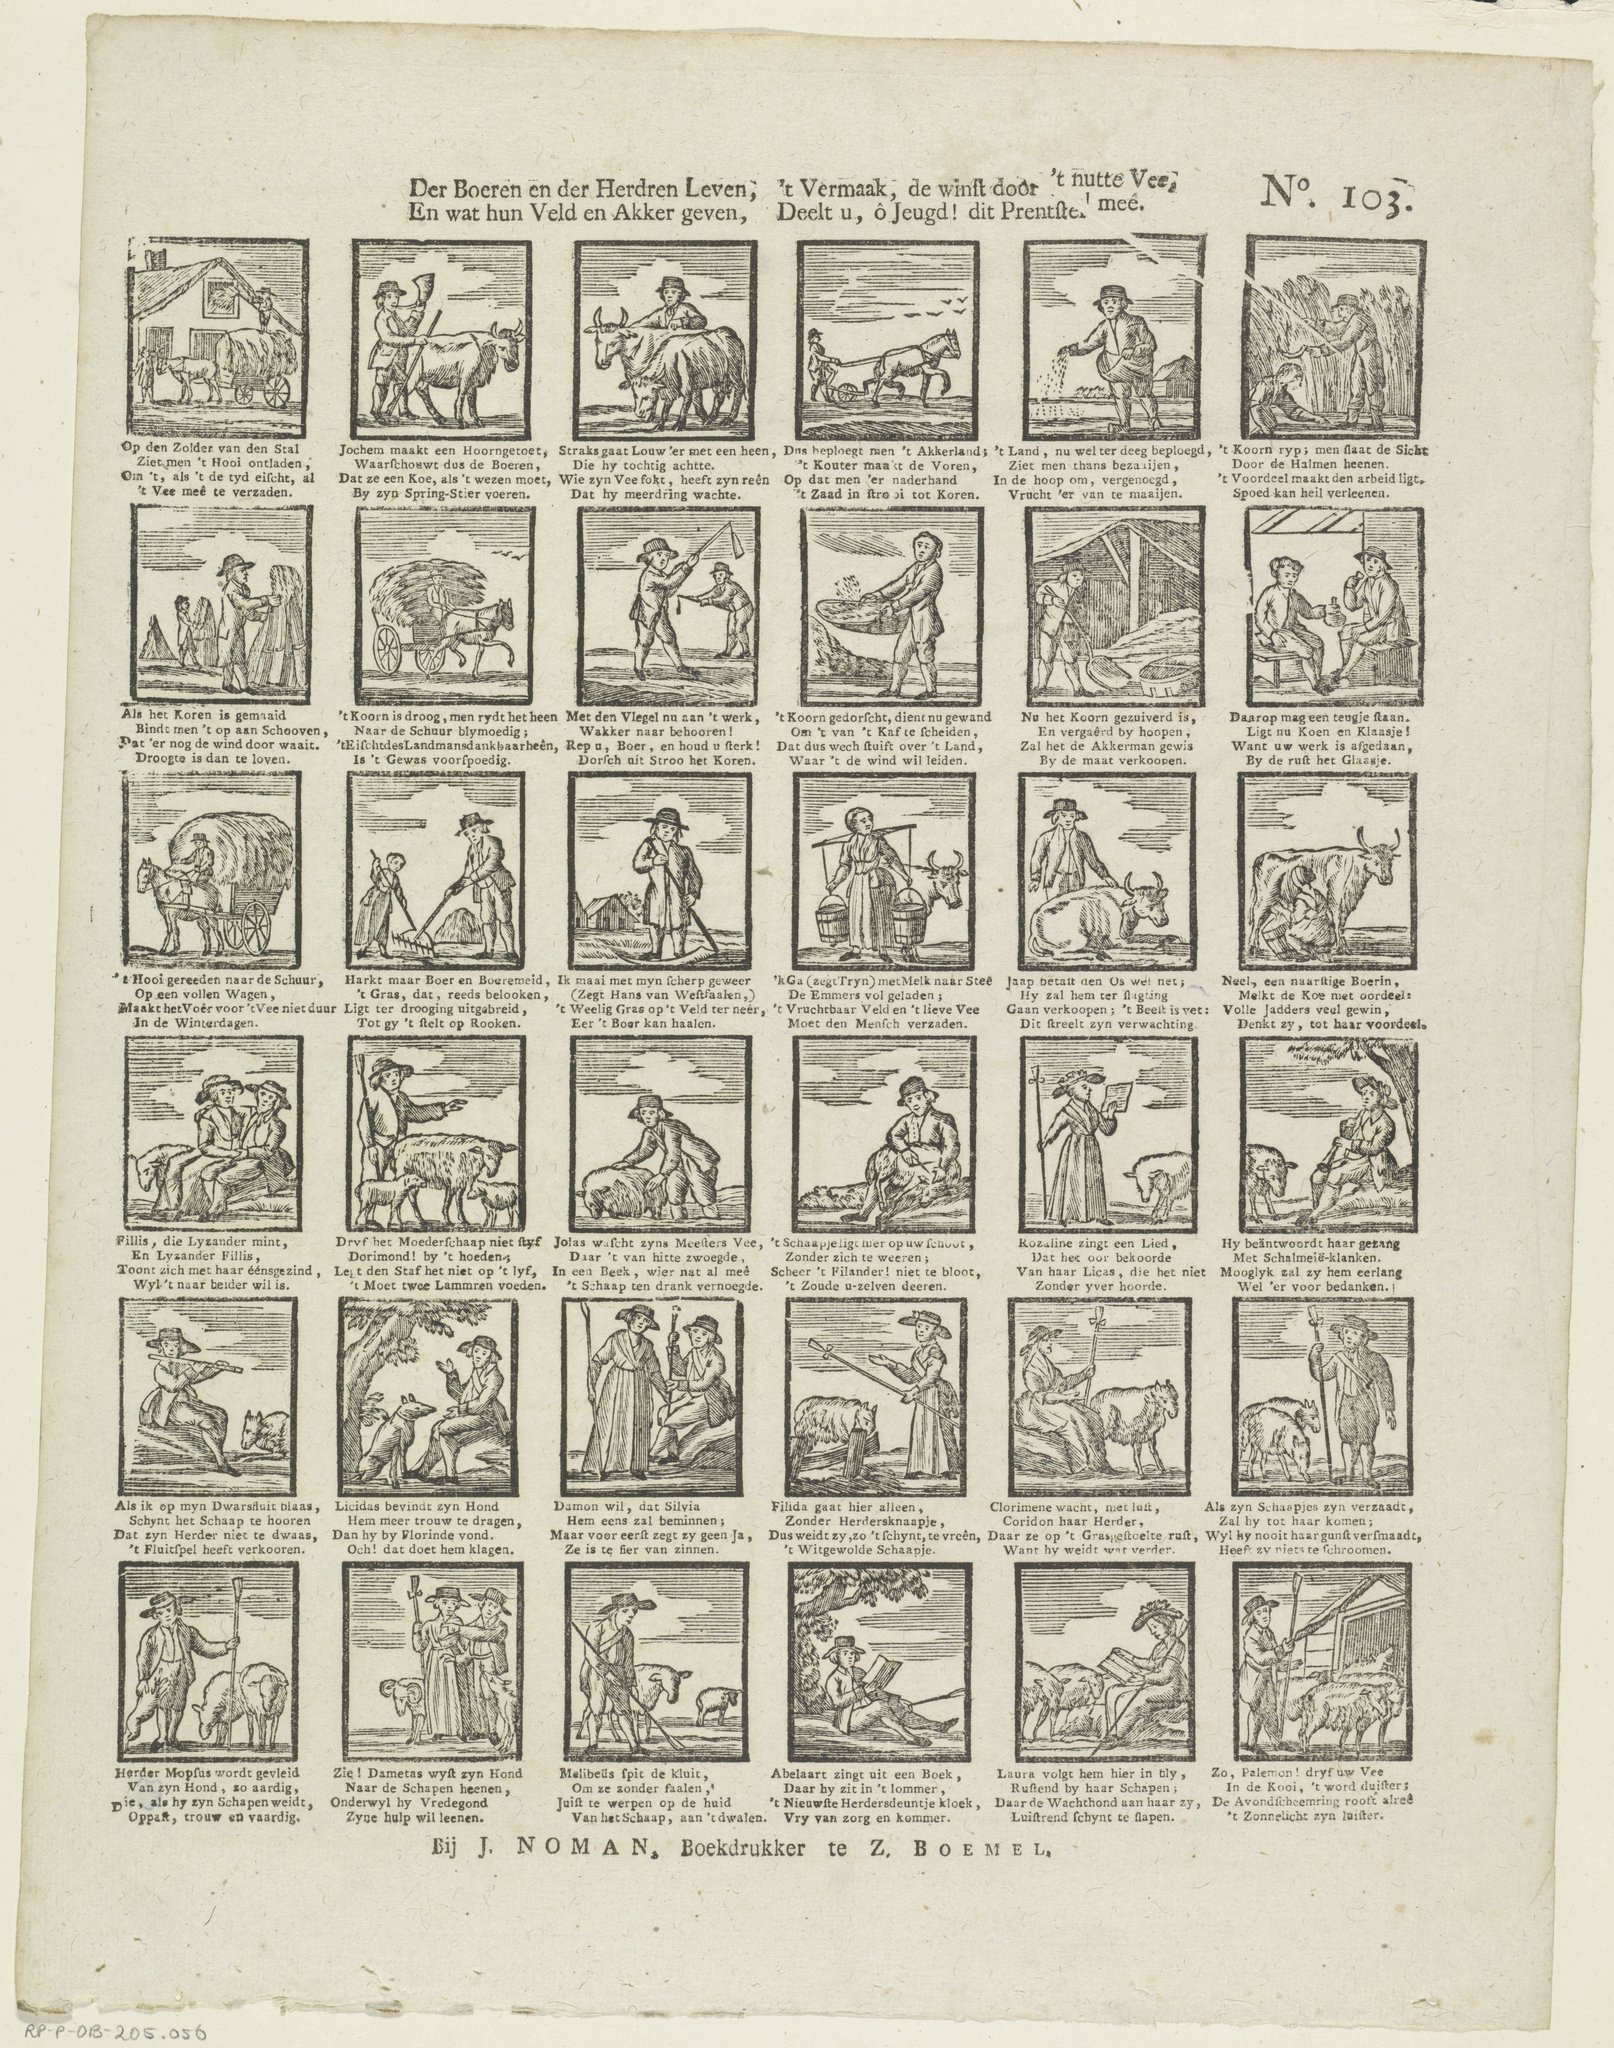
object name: popular print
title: De boeren en der herdren leven, / En wat hun veld en akker geven, / 't vermaak, de winst door 't nutte vee, / Deelt u, ô jeugd! dit prentstel meê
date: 1806-1830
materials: paper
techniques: letterpress printing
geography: zaltbommel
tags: herding, herdsman, herdswoman, shepherd, shepherdess, cowherd, etc., farmers, farmers - aa - female farmer, farmer's wife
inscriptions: collector's mark: Lugt 2760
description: Blad met 36 voorstellingen van de bezigheden van boeren, boerinnen, herders en herderinnen. Onder elke afbeelding een vierregelig vers. Genummerd rechtsboven: No. 103.